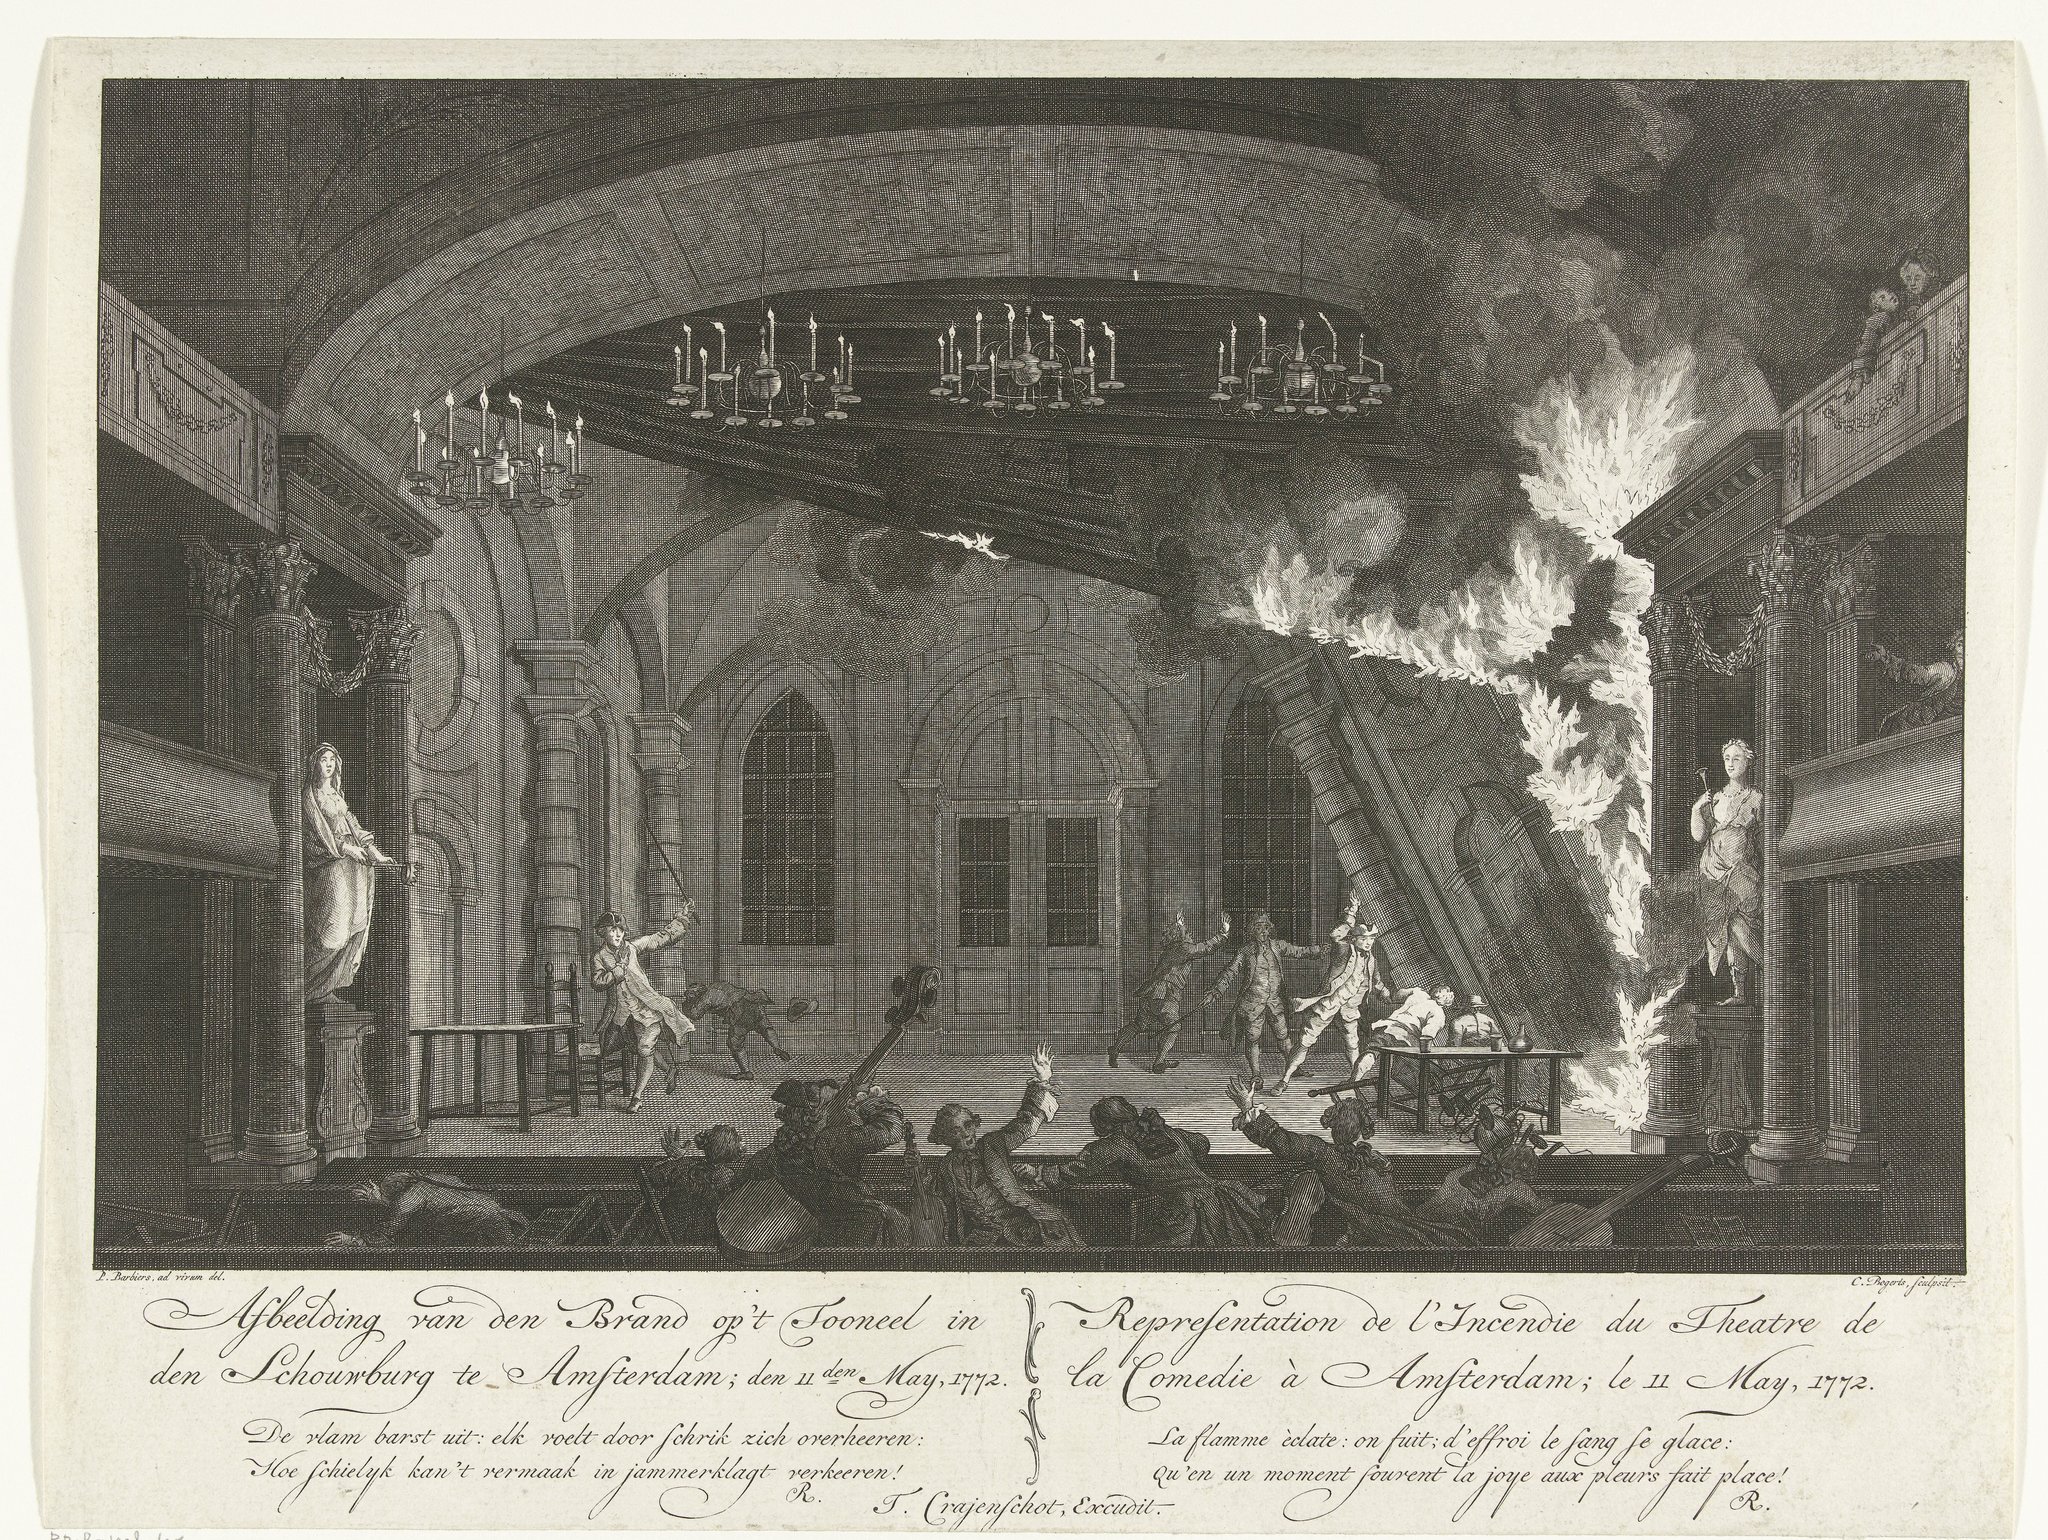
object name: print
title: De brand in de Amsterdamse Schouwburg, 1772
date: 1772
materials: paper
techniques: engraving, etching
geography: amsterdam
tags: on fire, ablaze, theatre, theatrical performance, large group of musicians, orchestra, theatre (building)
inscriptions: collector's mark: Lugt 2228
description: Gezicht op het toneel van de Amsterdamse Schouwburg tijdens het uitbreken van de brand op 11 mei 1772. De brand ontstond tijdens de uitvoering van de opera 'De Deserteur'. Op het toneel vluchten acteurs en rechts valt een brandend decorstuk om. Op de voorgrond vluchten musici de orkestbak uit. Onder de voorstelling de titel en een tweeregelig vers in het Nederlands (links) en Frans (rechts). Onderdeel van een serie van vier prenten met titelprent over de brand in de Amsterdamse Schouwburg.